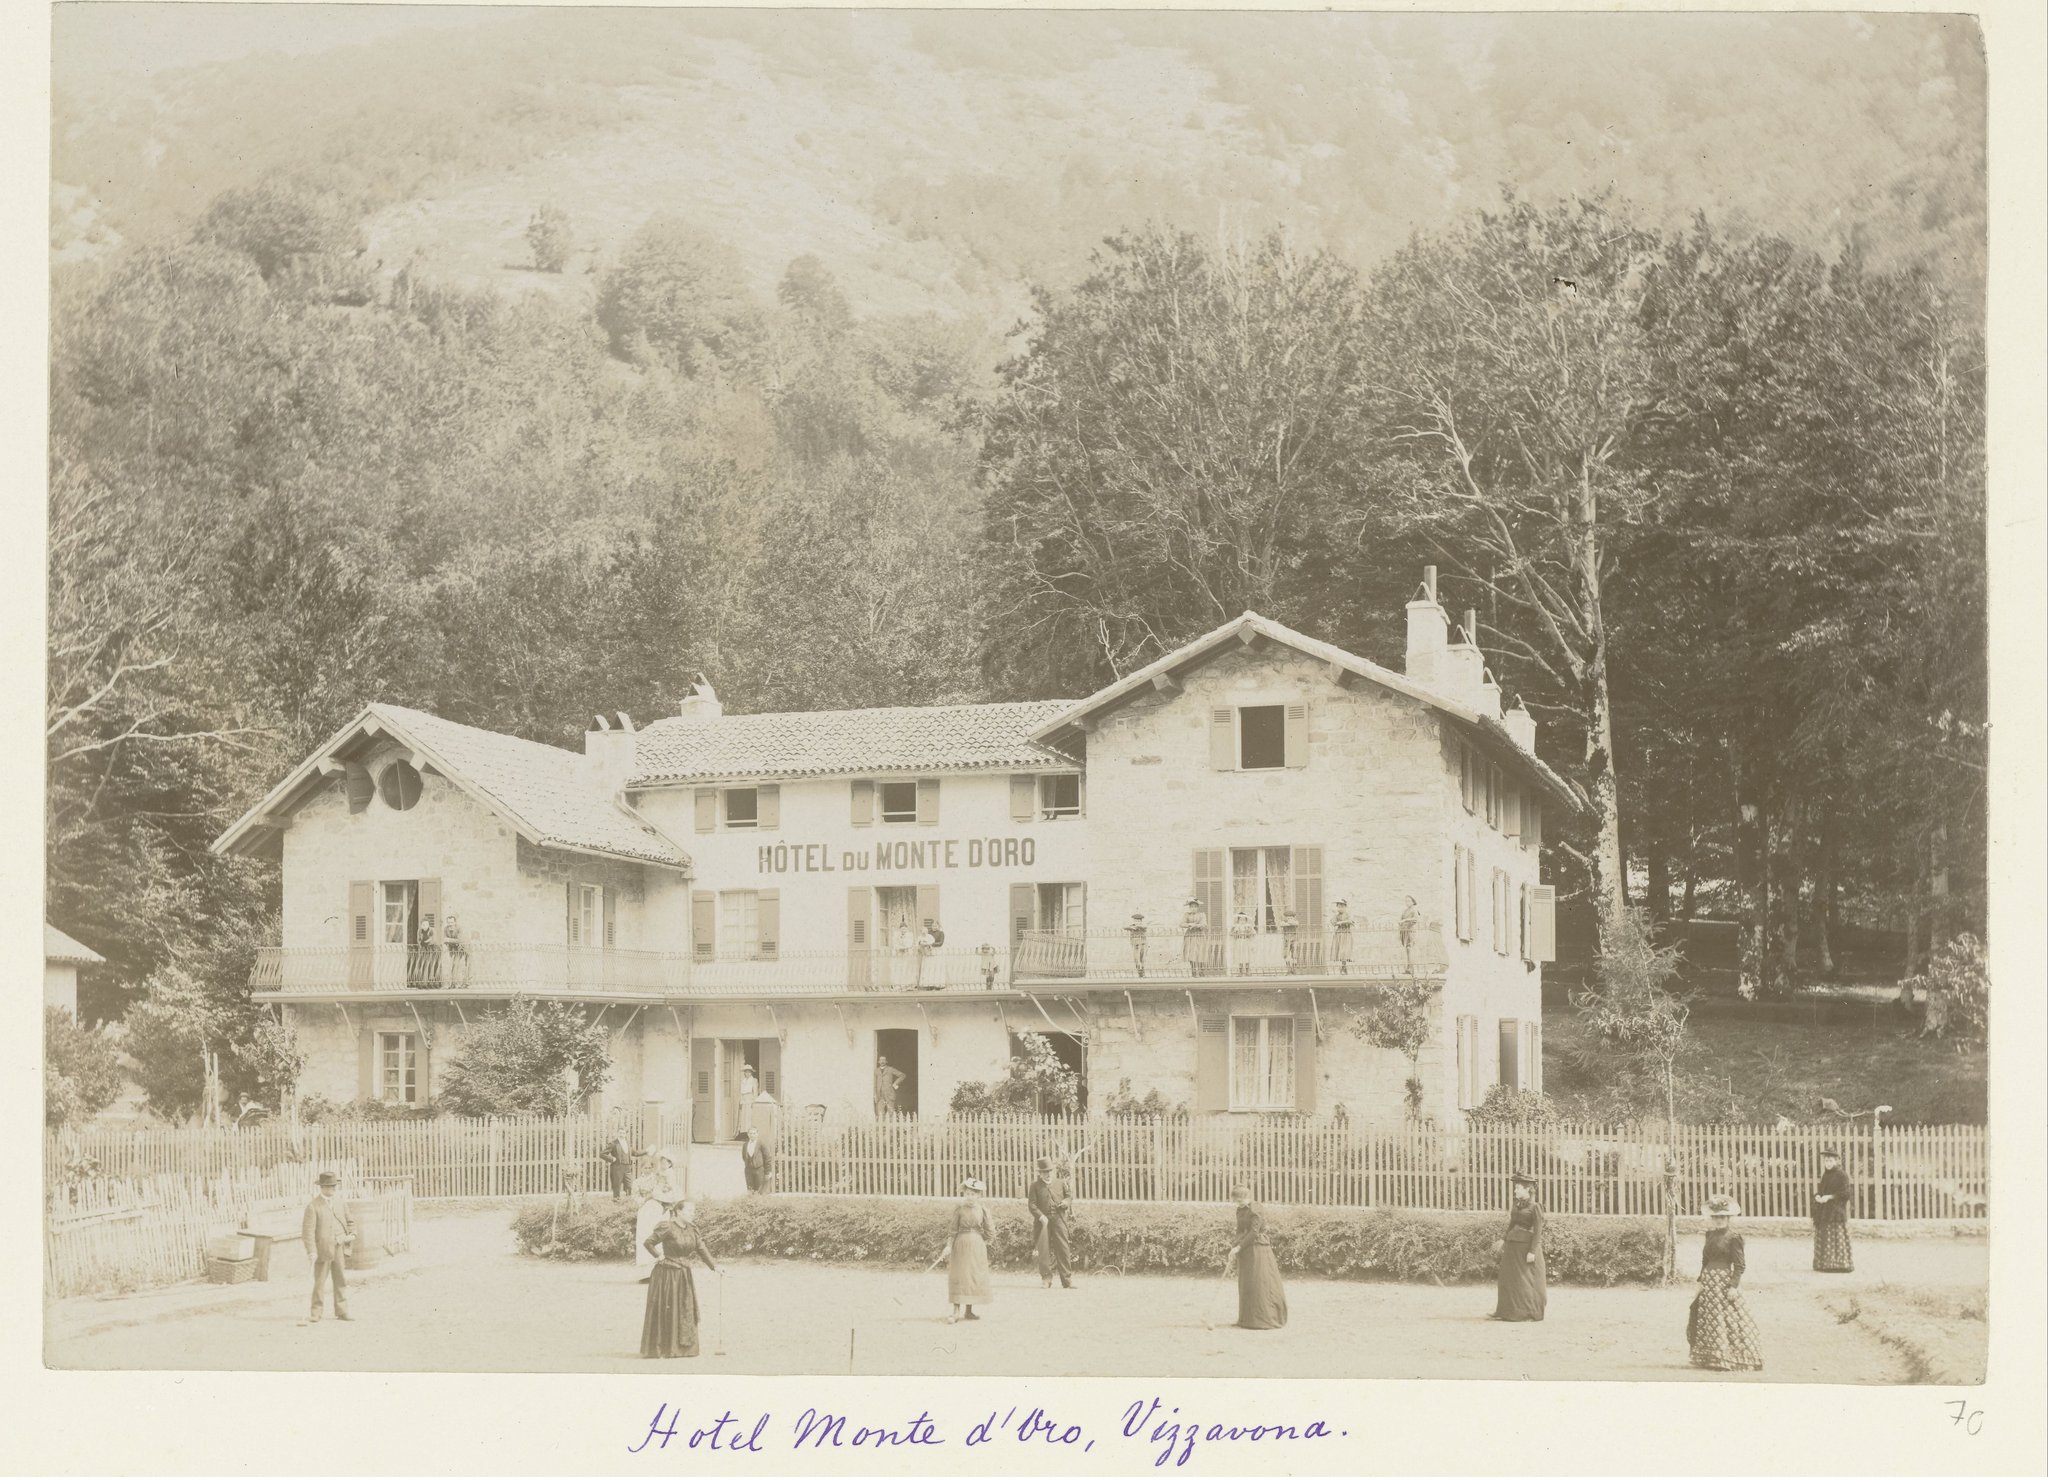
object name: photograph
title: Hotel Monte D'Oro, Vizzavona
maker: henry pauw van wieldrecht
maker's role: fotograaf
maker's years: 1863-1912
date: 1886-1896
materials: cardboard, photographic support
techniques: albumen print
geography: corsica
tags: corsica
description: Hotel monte d'Oro in Vizzavona. Op de voorgrond, voor het hotel speelt een groep mensen croquet .